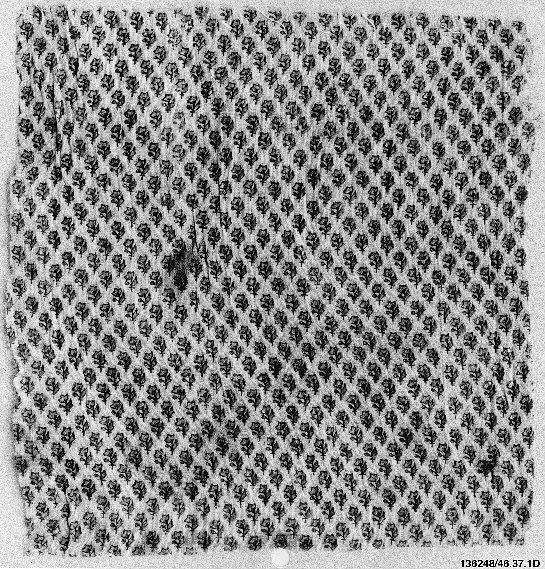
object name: textile fragment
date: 1701-1800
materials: cotton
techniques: painting, printing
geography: india